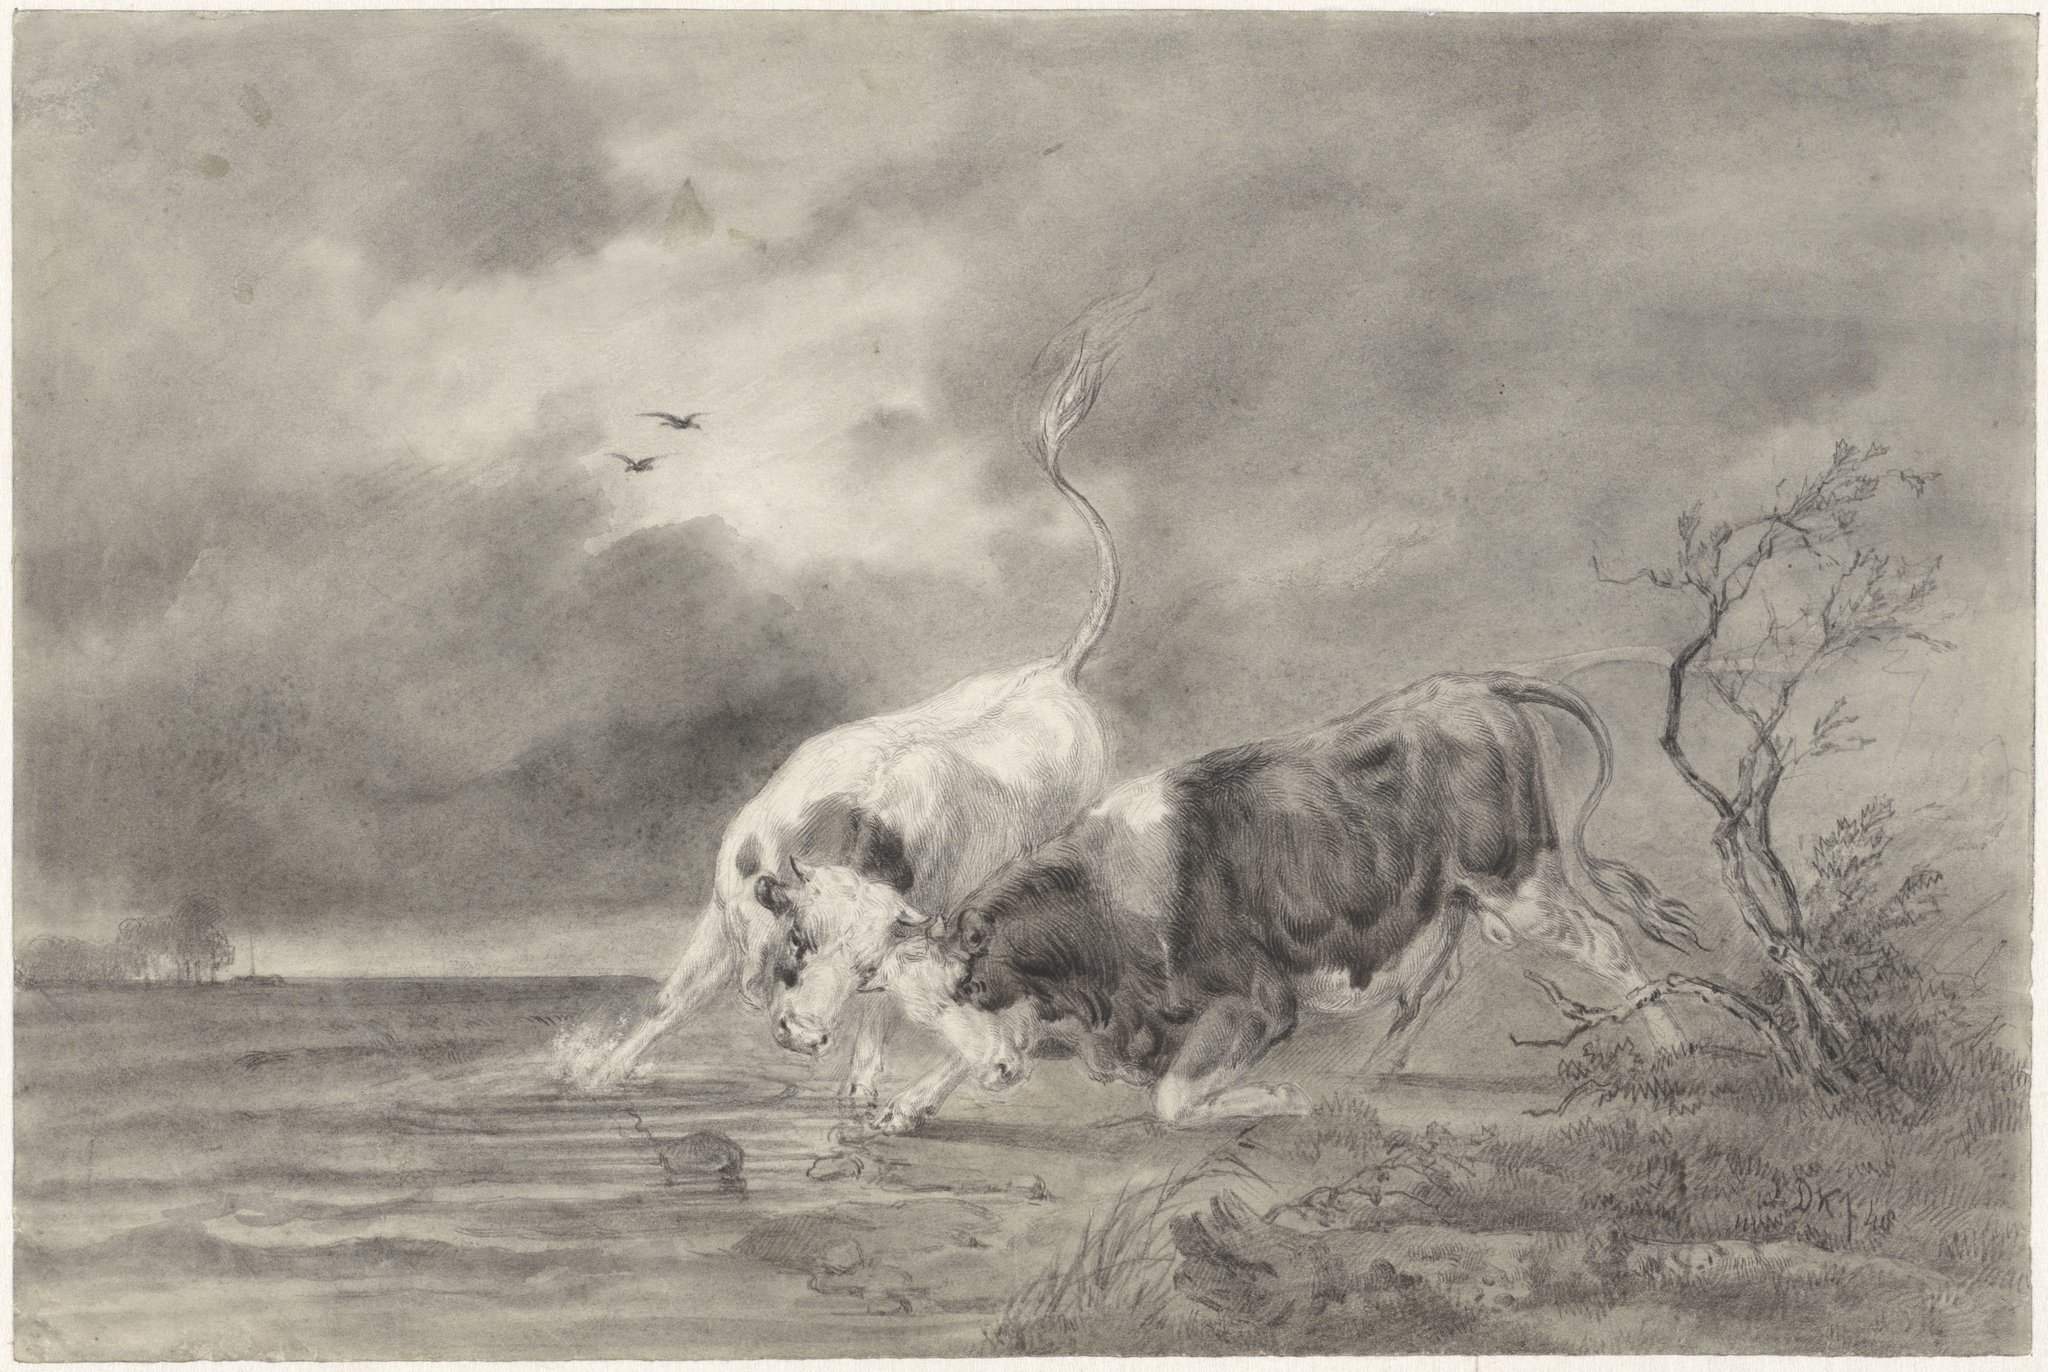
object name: drawing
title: Twee vechtende stieren in een rivierlandschap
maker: johan daniël koelman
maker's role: draughtsman, print maker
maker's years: 1831-1857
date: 1848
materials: chalk, paper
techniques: brush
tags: bull, river